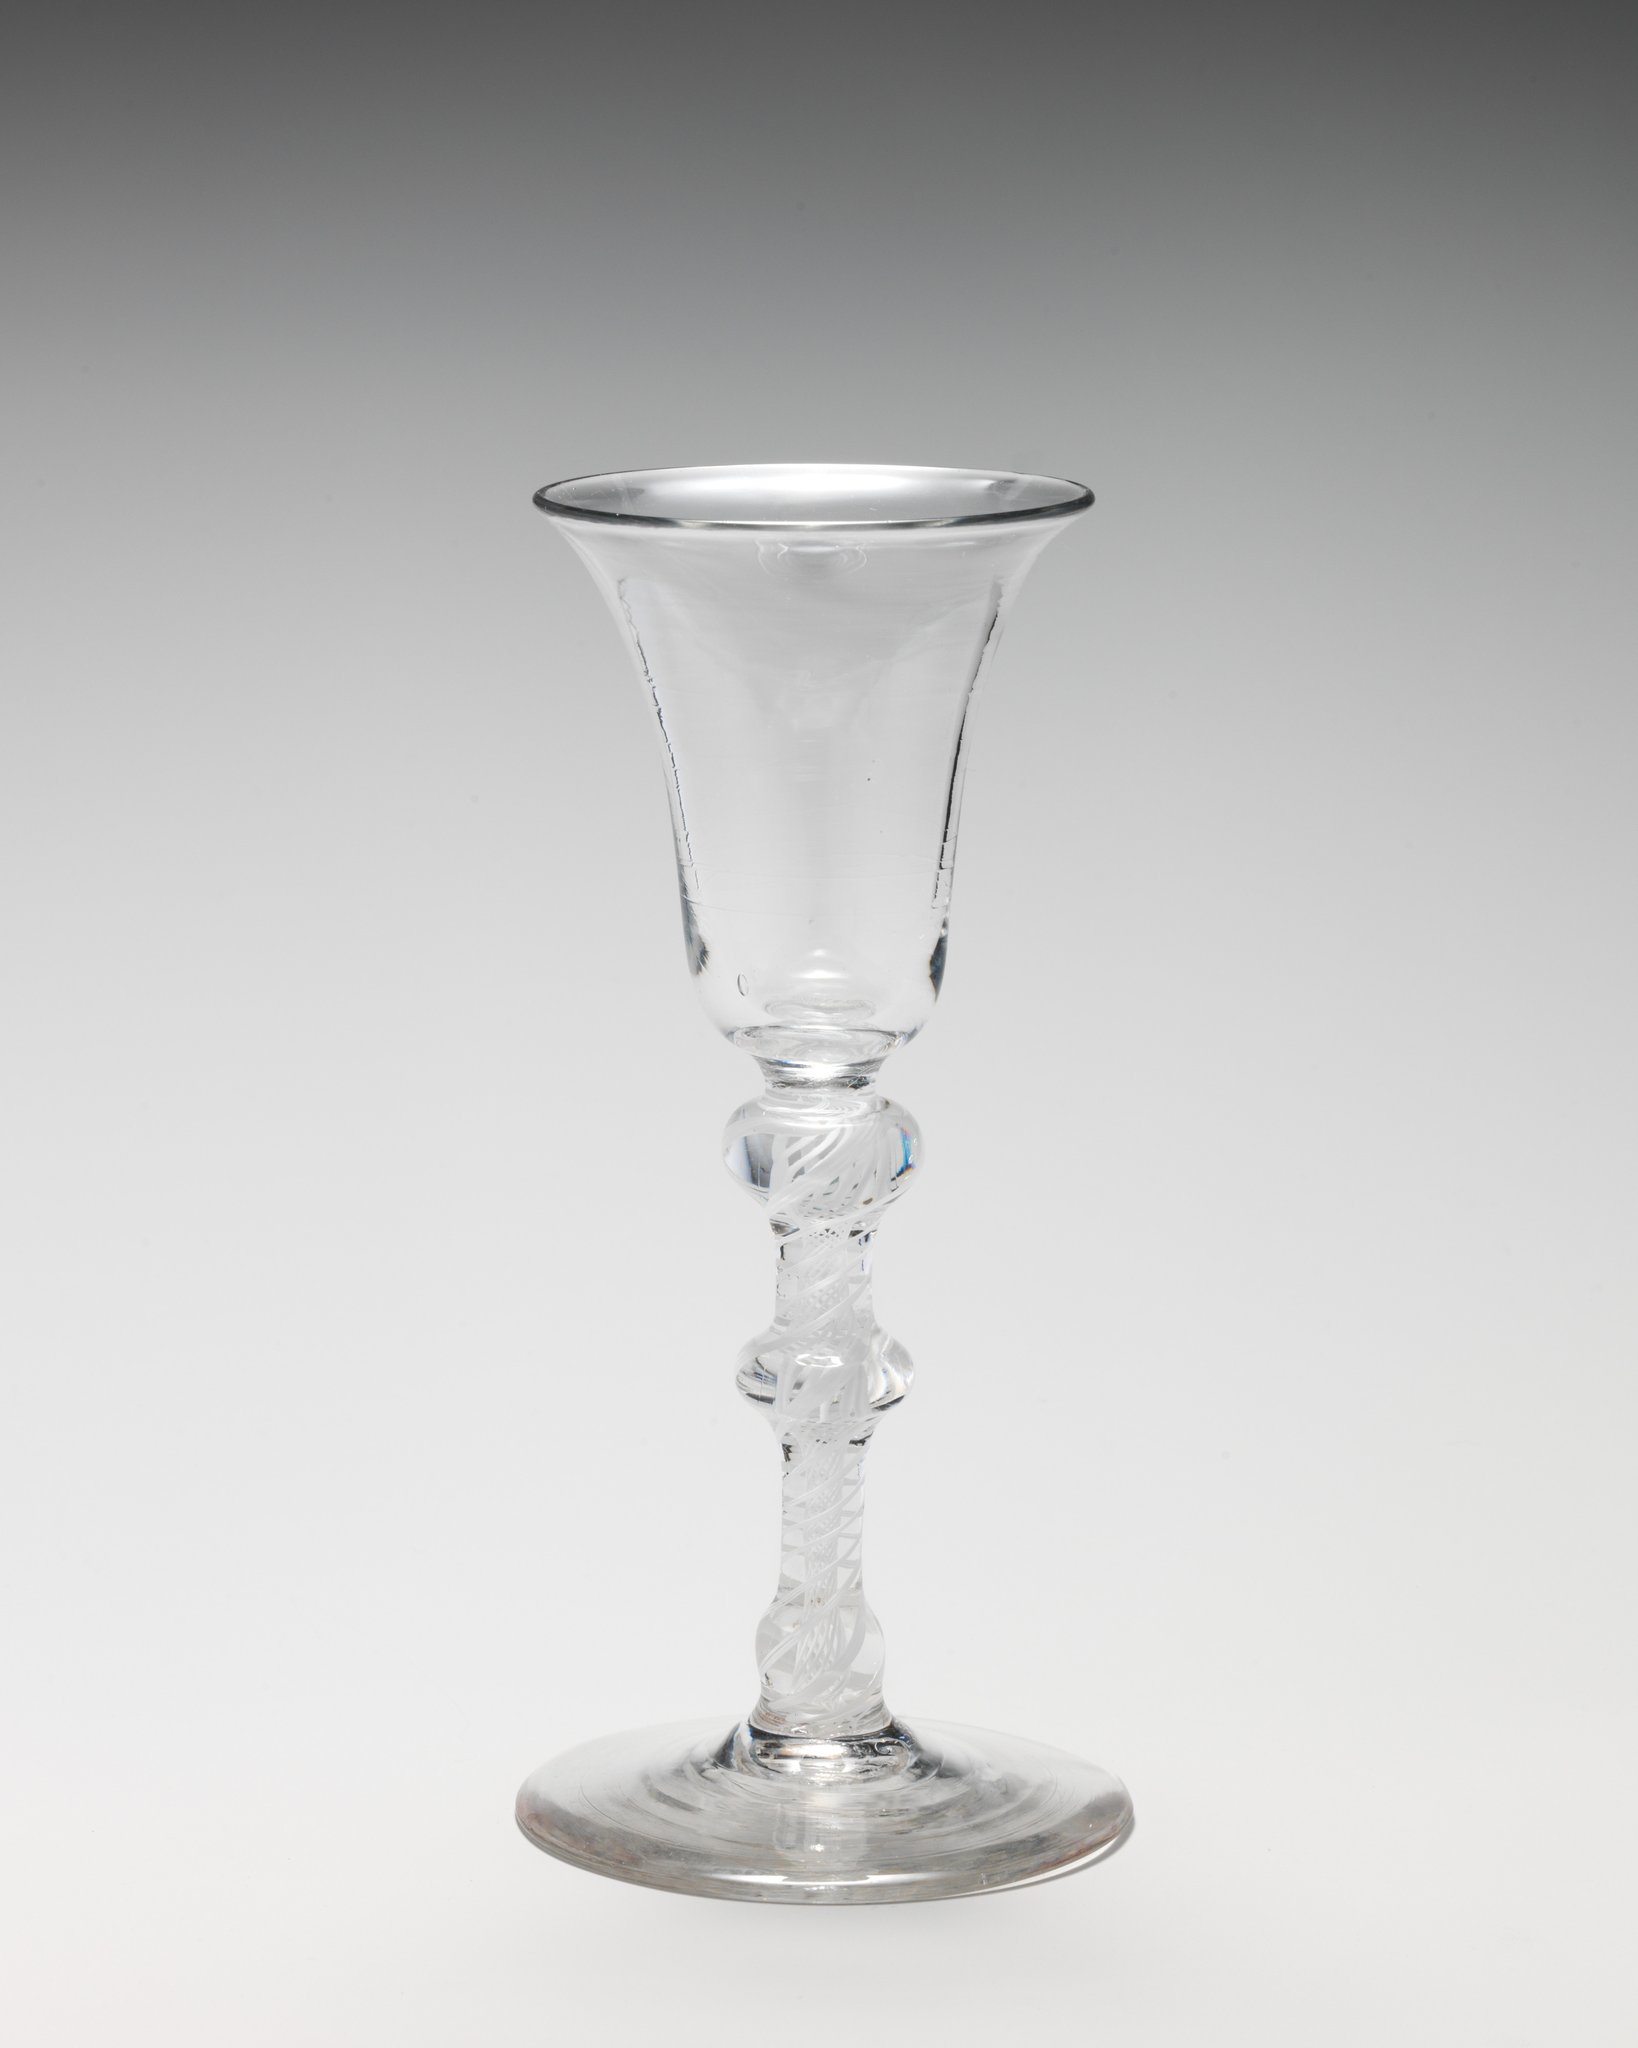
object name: wineglass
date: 1701-1800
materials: glass